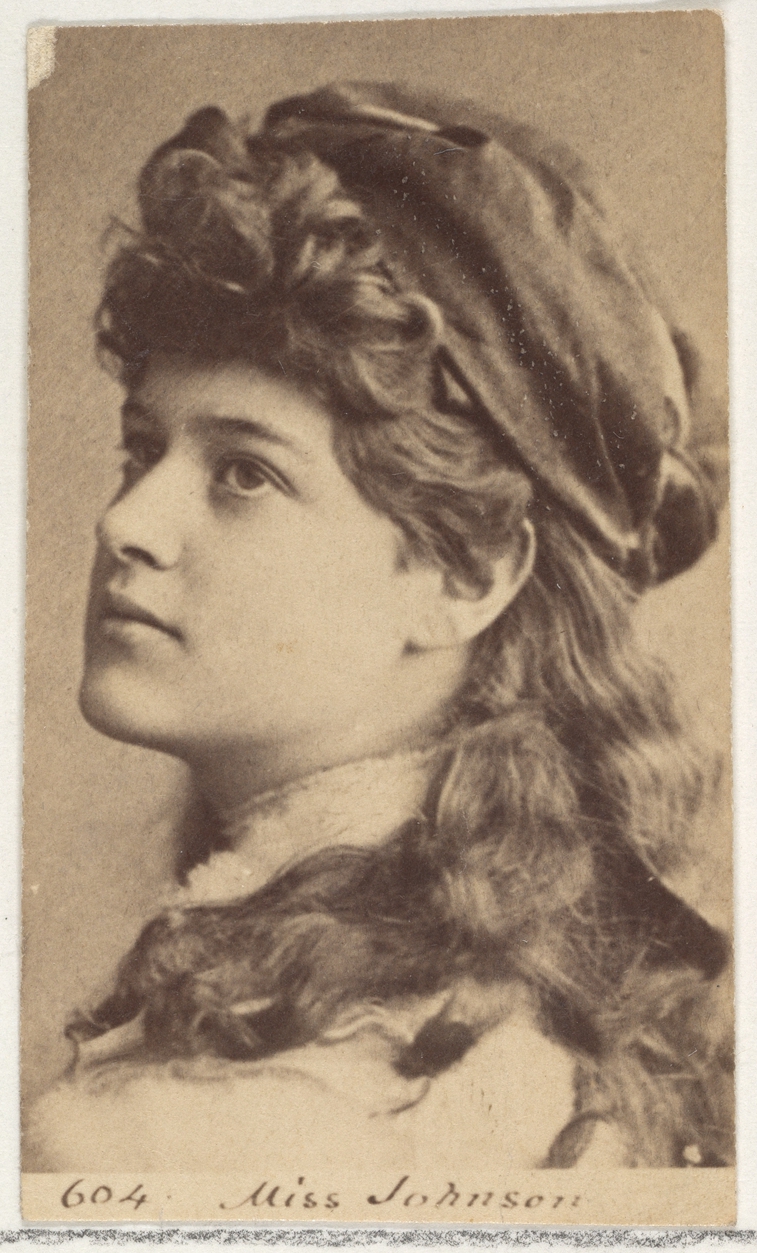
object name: photograph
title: Card 604, Miss Johnson, from the Actors and Actresses series (N45, Type 1) for Virginia Brights Cigarettes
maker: allen & ginter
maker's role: publisher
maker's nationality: american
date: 1888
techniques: albumen silver print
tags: portraits,women,actresses